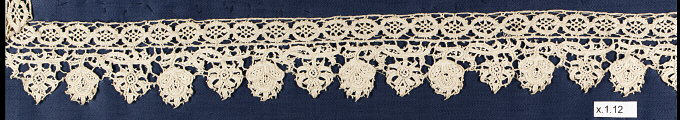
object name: fragment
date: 1601-1633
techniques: lace